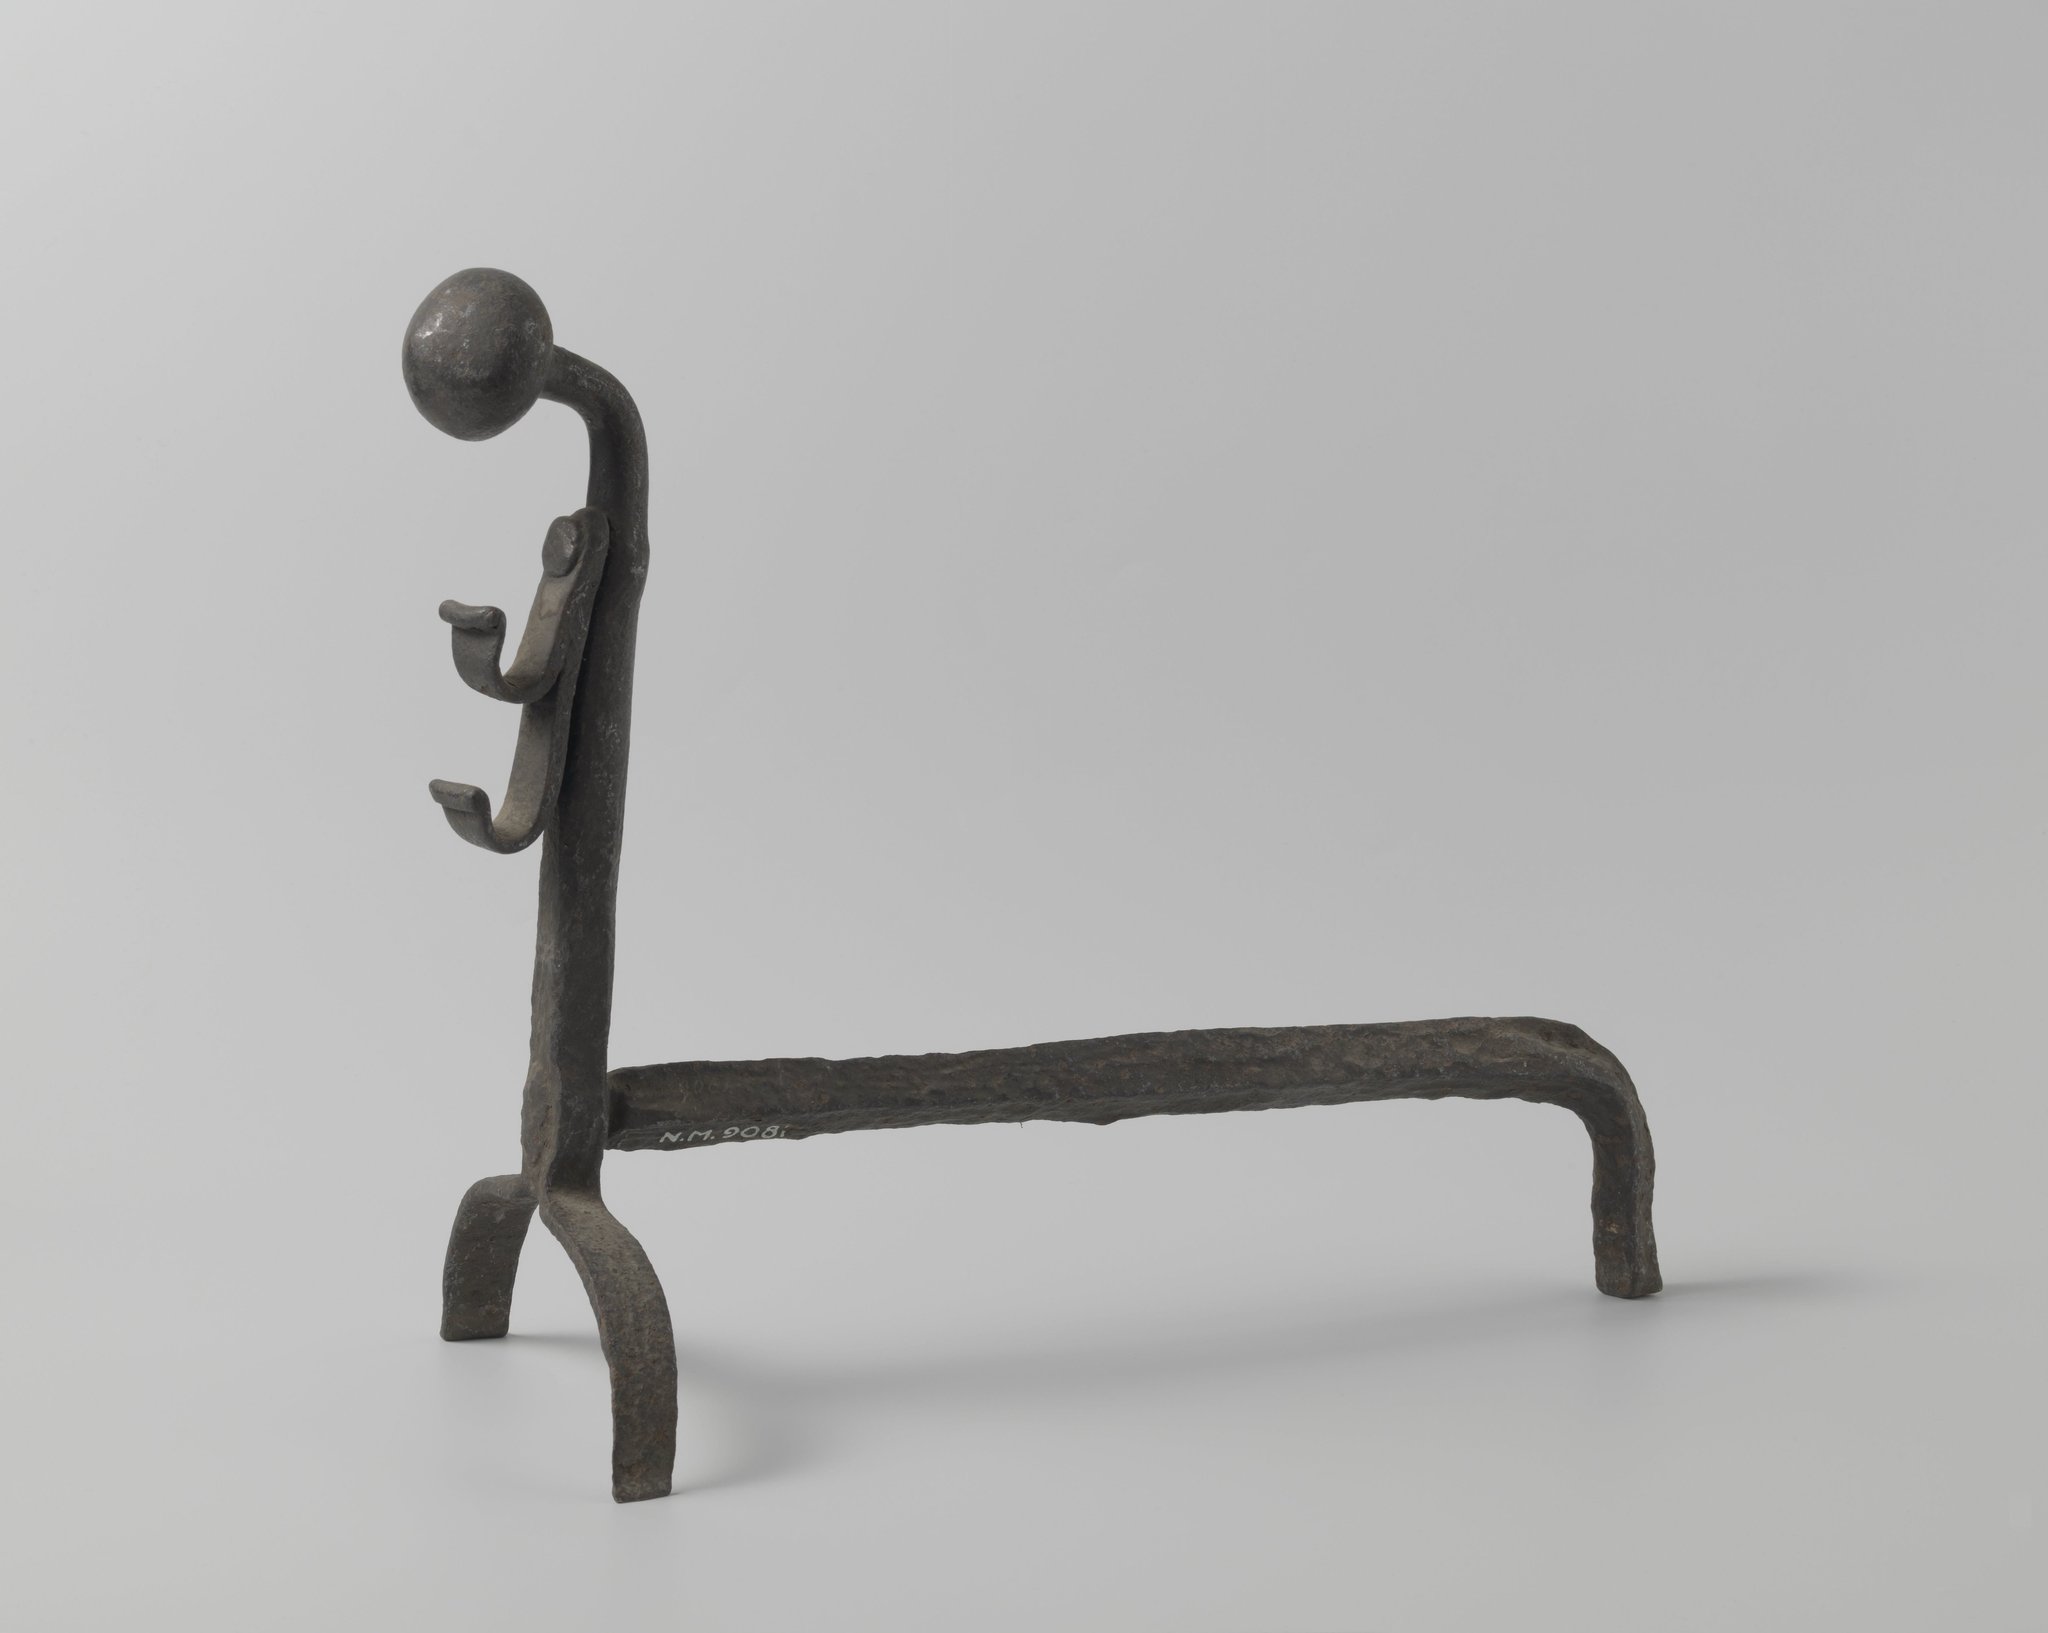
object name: vuurijzer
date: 1000-2000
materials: iron